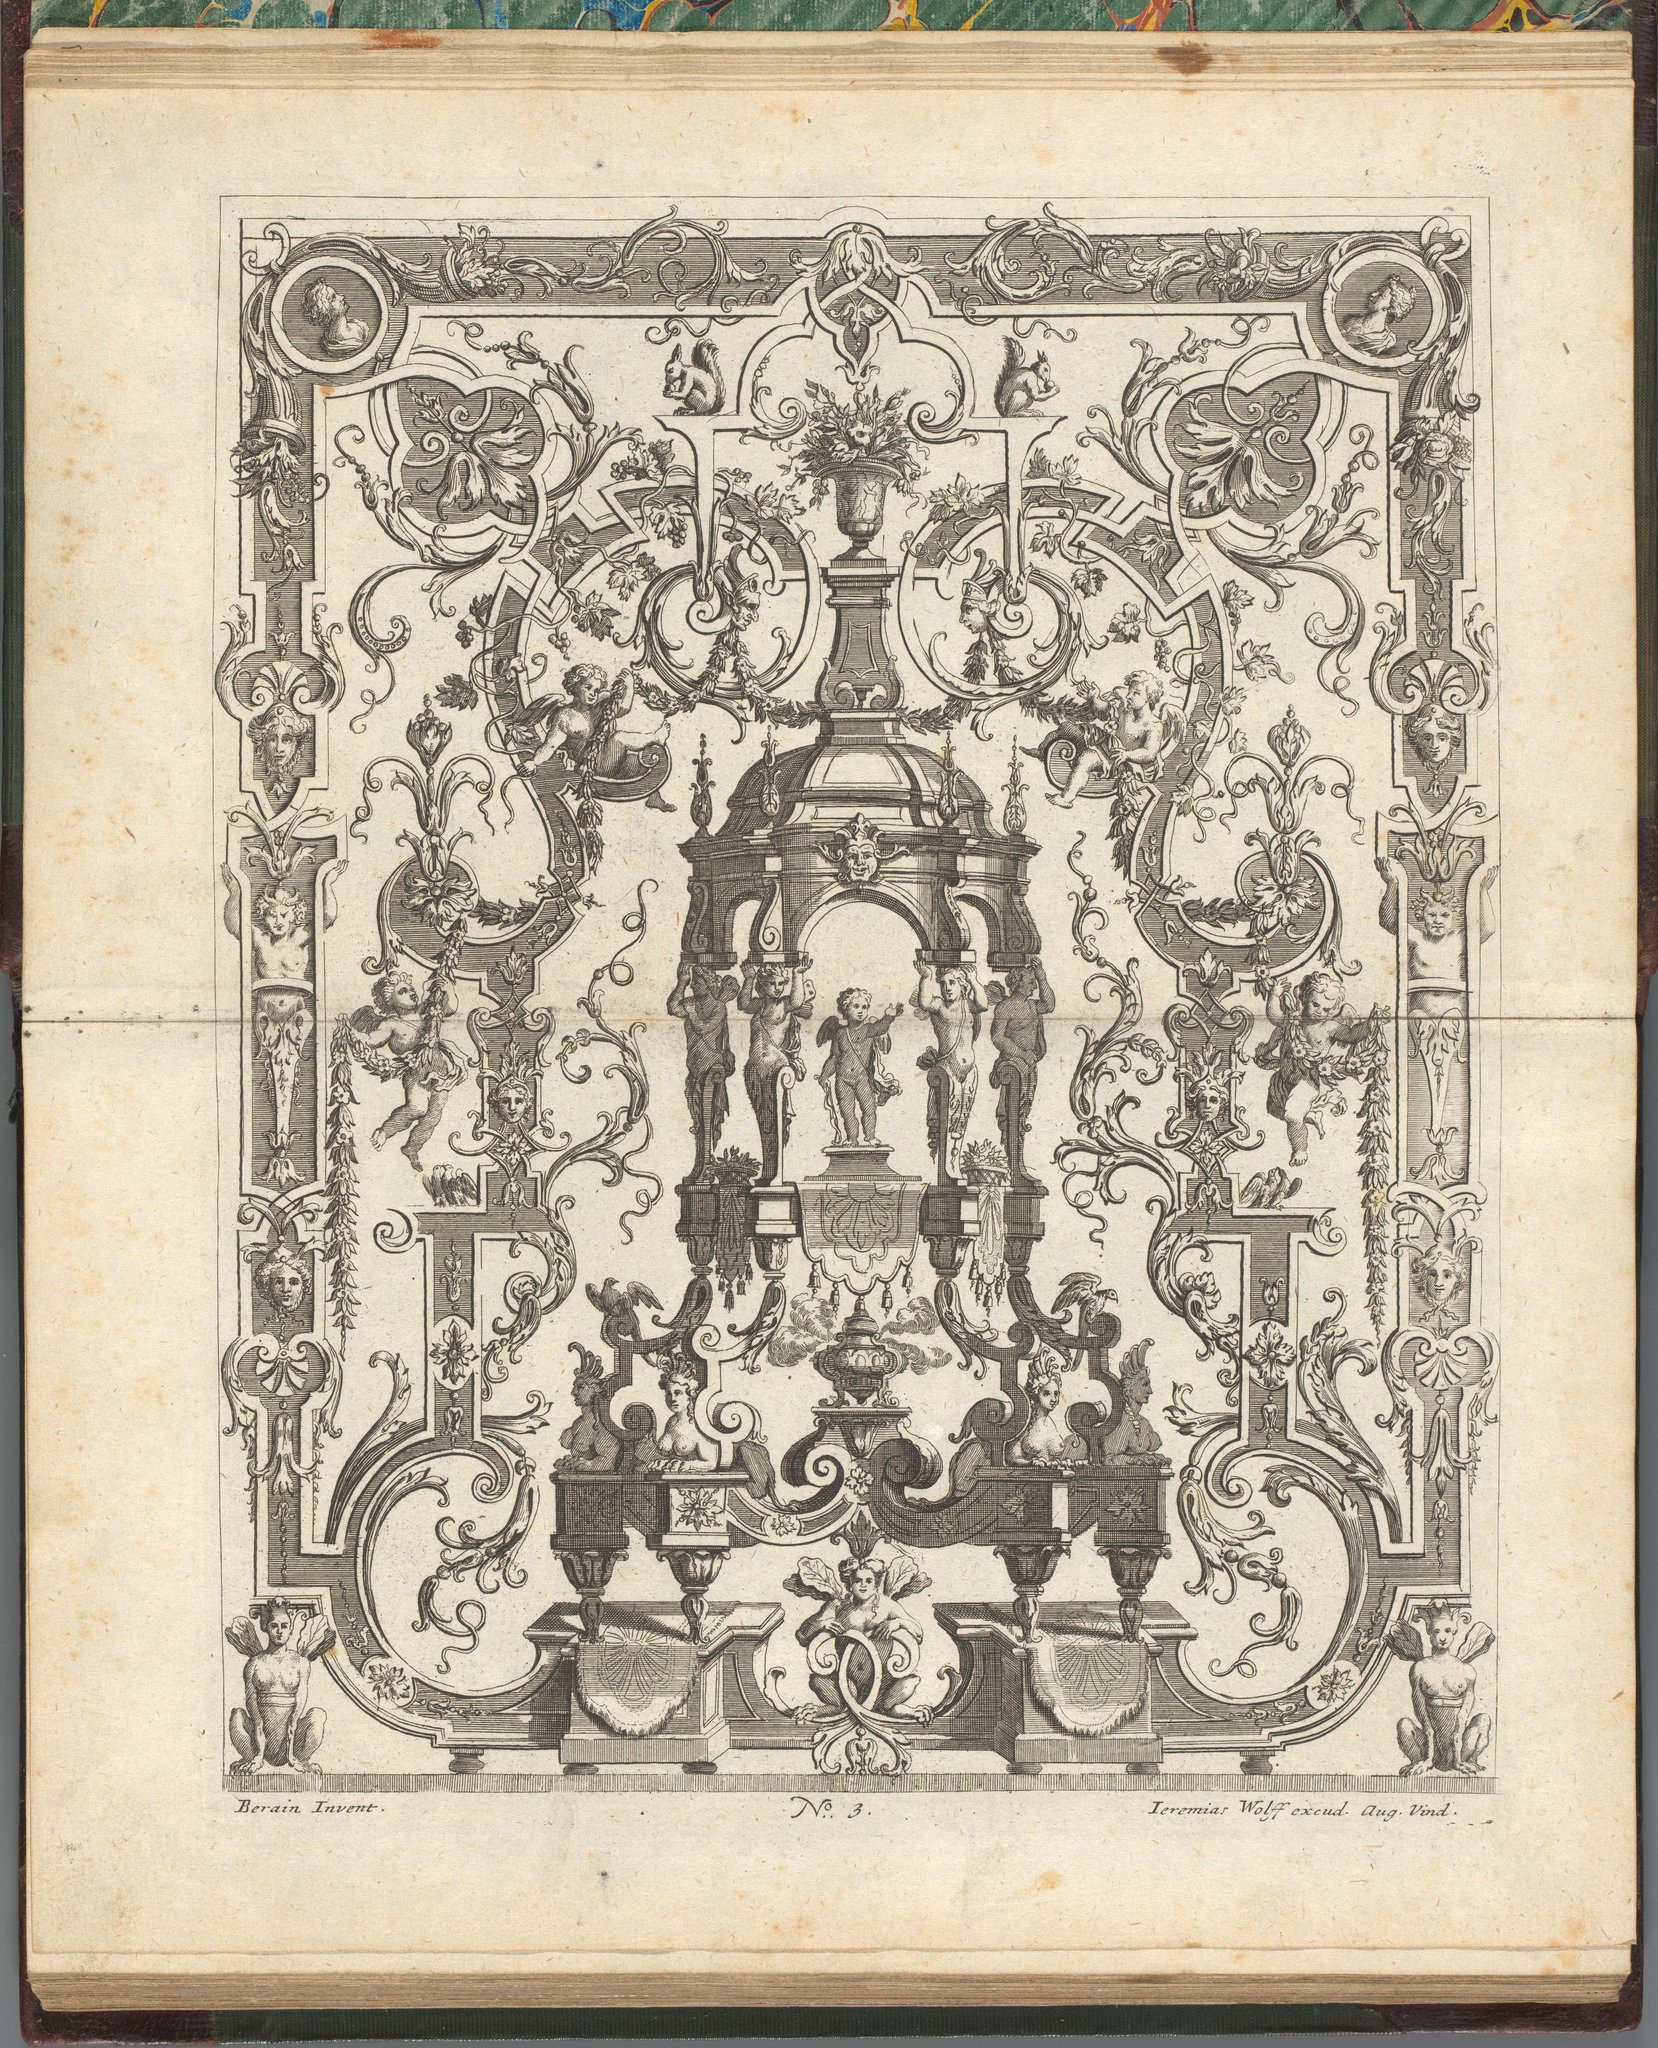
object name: print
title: Compositie met Amor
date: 1686-1724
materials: paper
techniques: etching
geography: augsburg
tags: ornaments ~ art, atlantes ~ architecture, sphinx (lion/woman); 'sfinge' (ripa), censer, (story of) cupid, amor (eros), mask, mascaron ~ ornament, cupids: 'amores', 'amoretti', 'putti'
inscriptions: signature: ‘Ieremias Wolff excud. Aug. Vind.’, signature: ‘Berain Invent.’, number: ‘No. 3.’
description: Een decoratieve compositie met vlechtwerk en in het midden Amor in een koepel gedragen door atlanten. Onder hem een wierookvat geflankeerd door sfinxen. Door de hele voorstelling zijn dieren, putti en maskers afgebeeld. Prent maakt deel uit van een album. Hoogstwaarschijnlijk gespiegelde kopie naar Frans origineel.